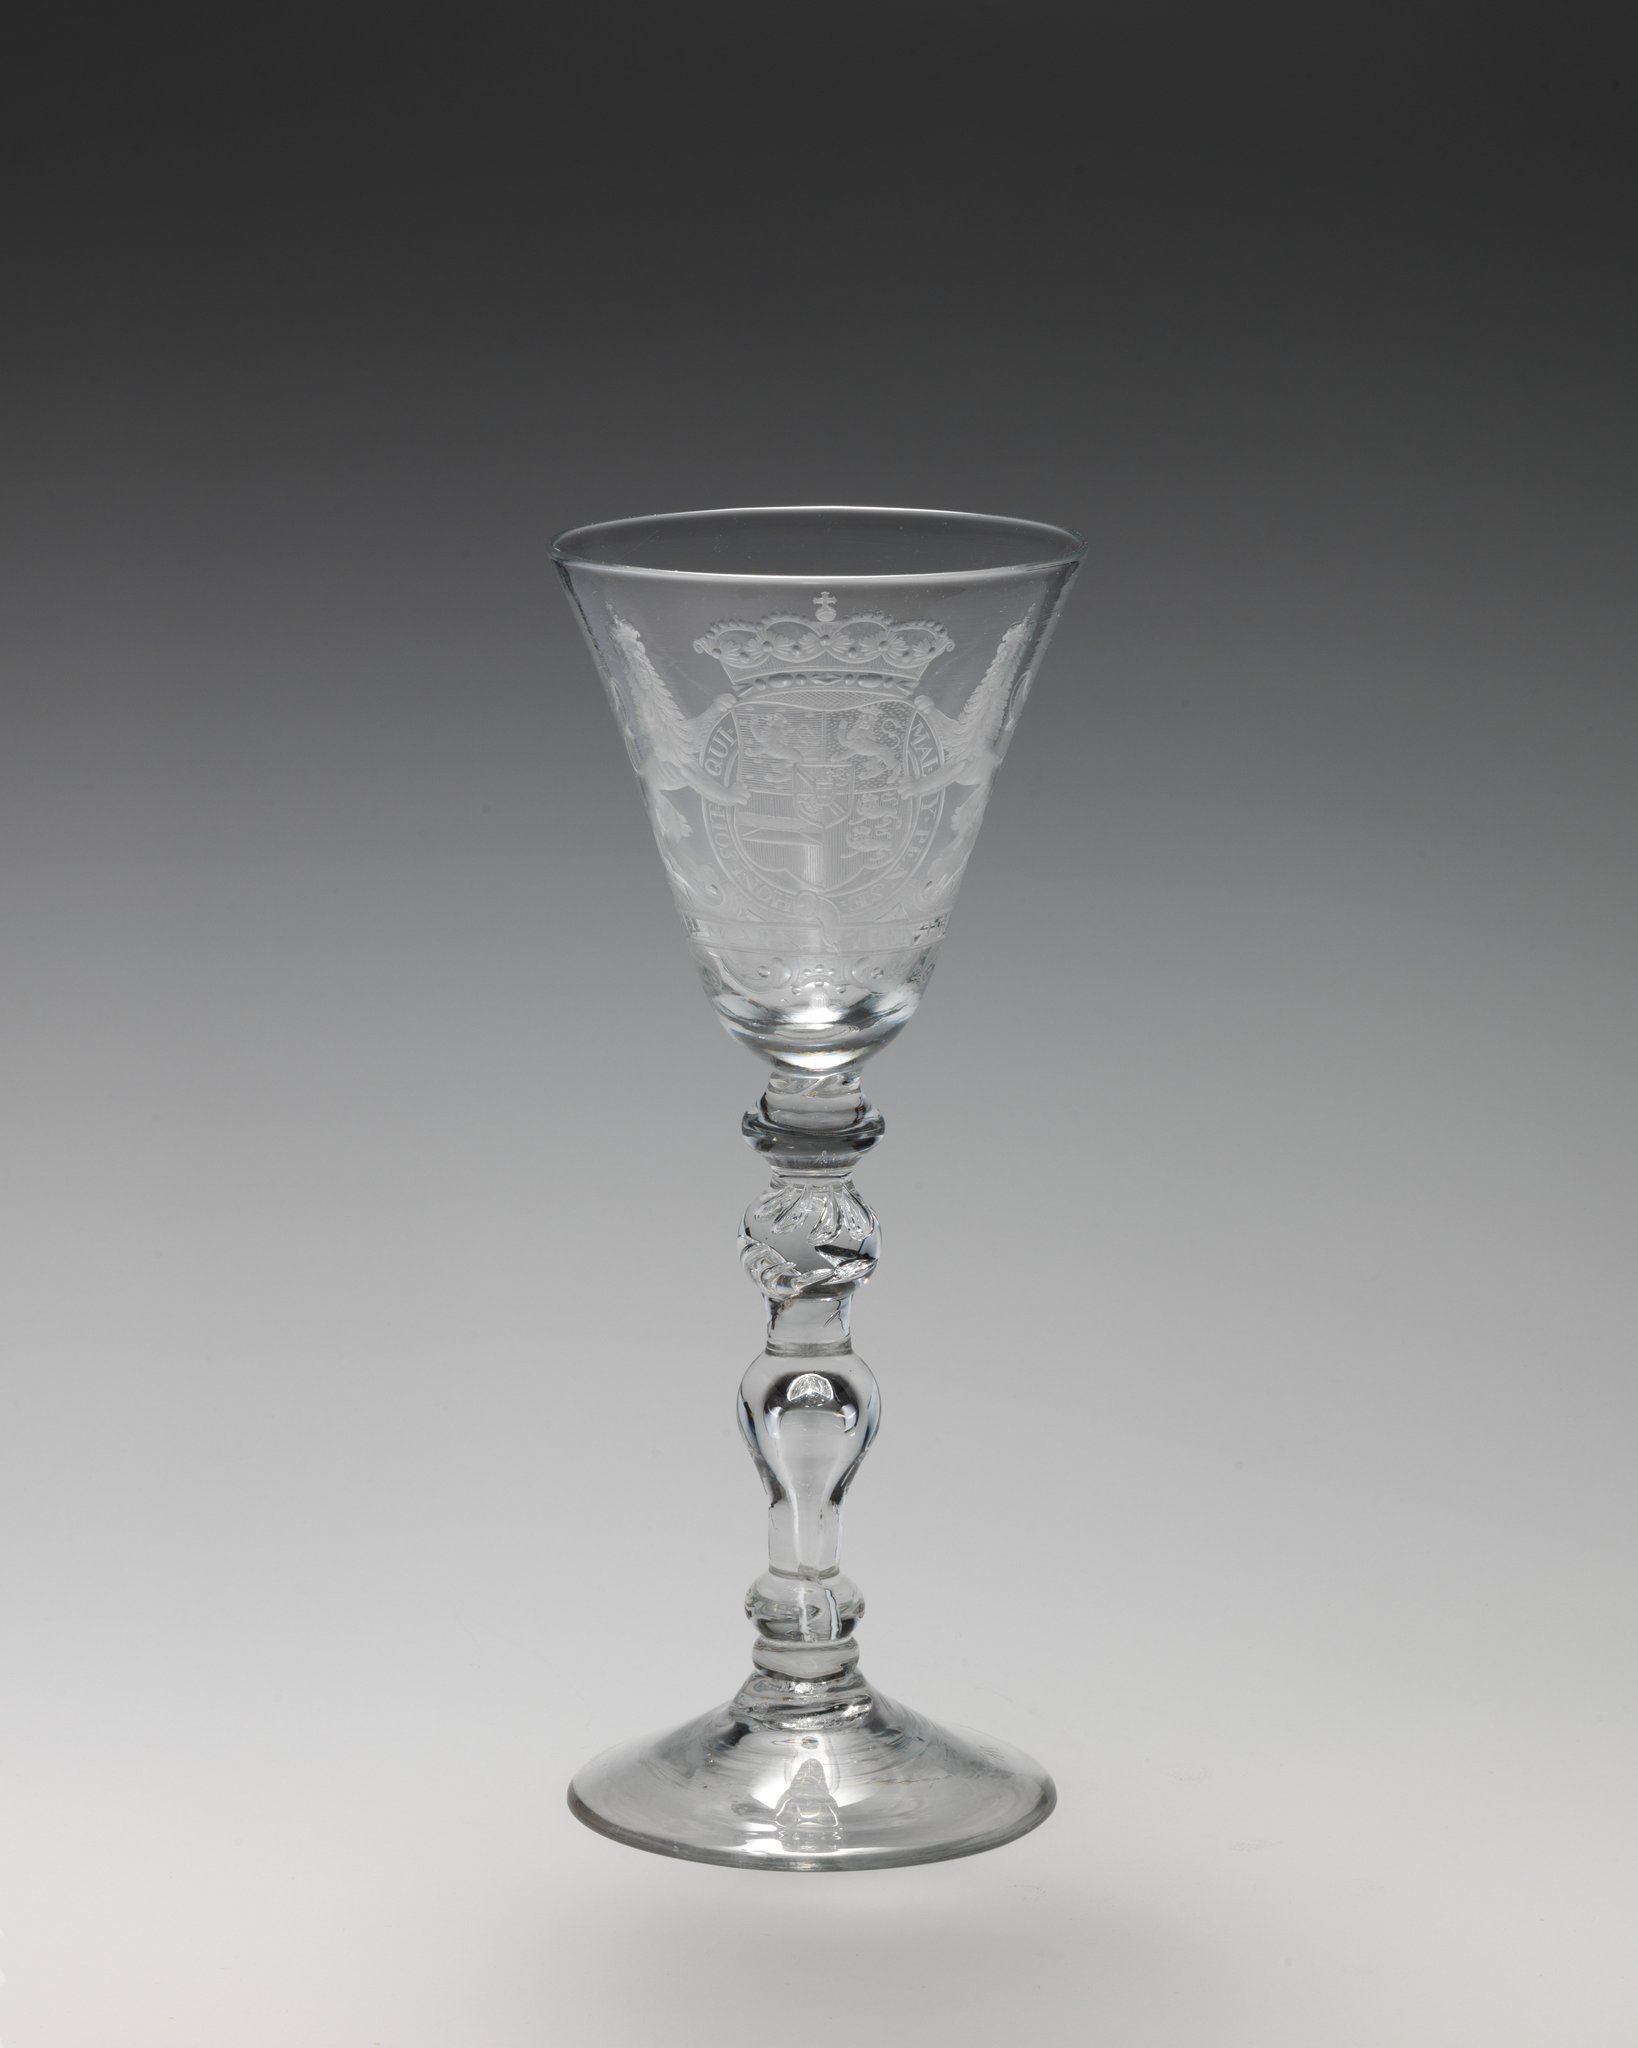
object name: wineglass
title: Wineglass with arms of William V, Prince of Orange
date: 1752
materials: glass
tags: coat of arms